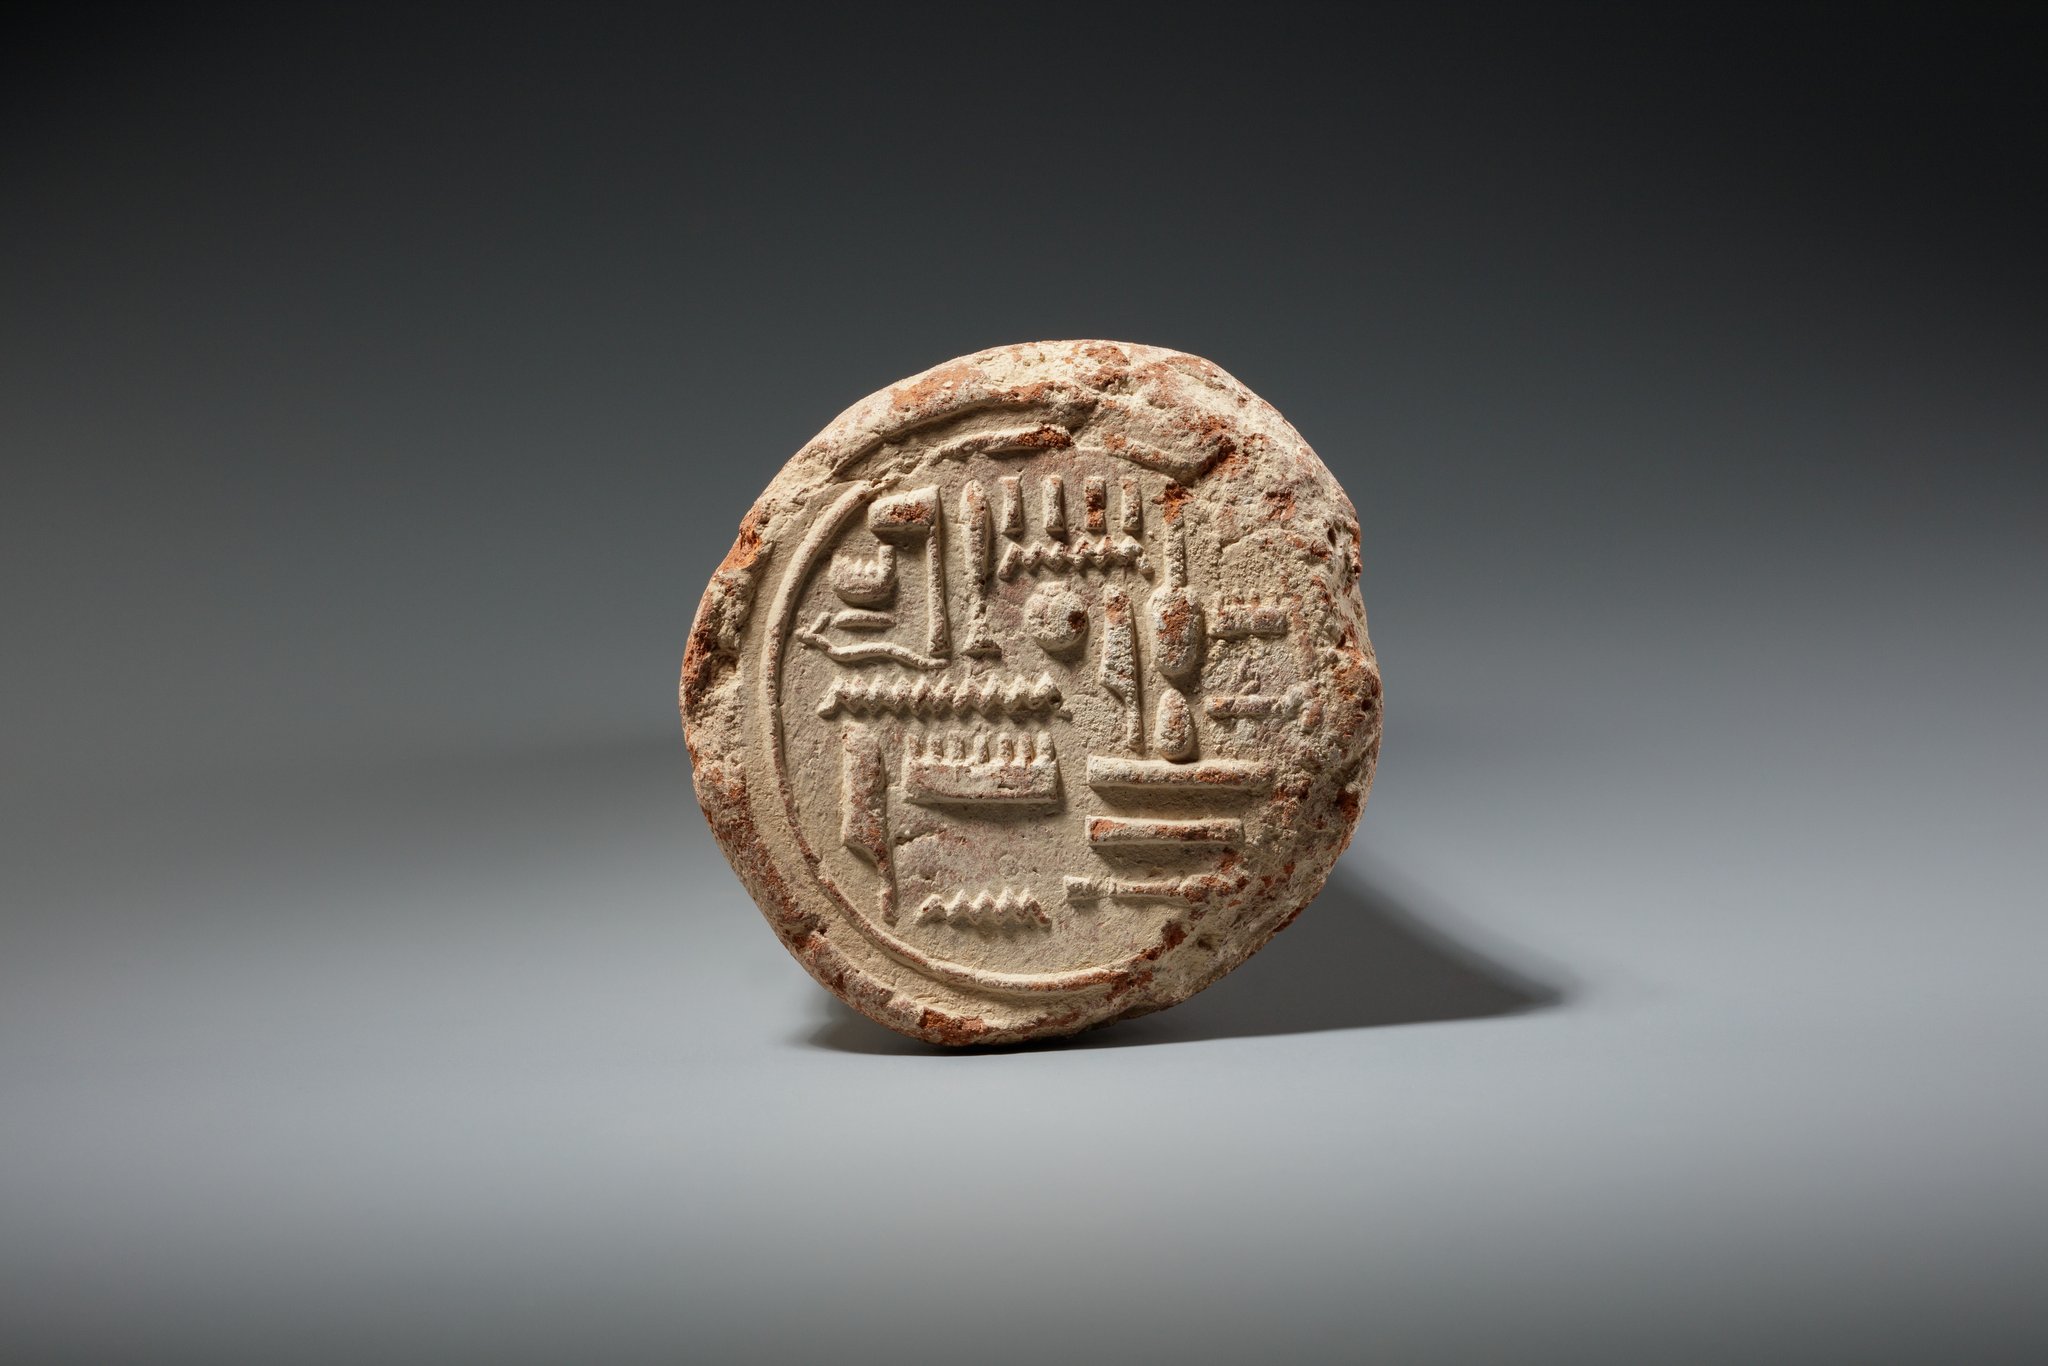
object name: cone, davy 359, neferhotep, priest, amun, amenhotep, house mistress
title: Funerary Cone Neferhotep and His Wife Amenhotep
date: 1504-1458 BCE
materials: pottery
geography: egypt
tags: hieroglyphs